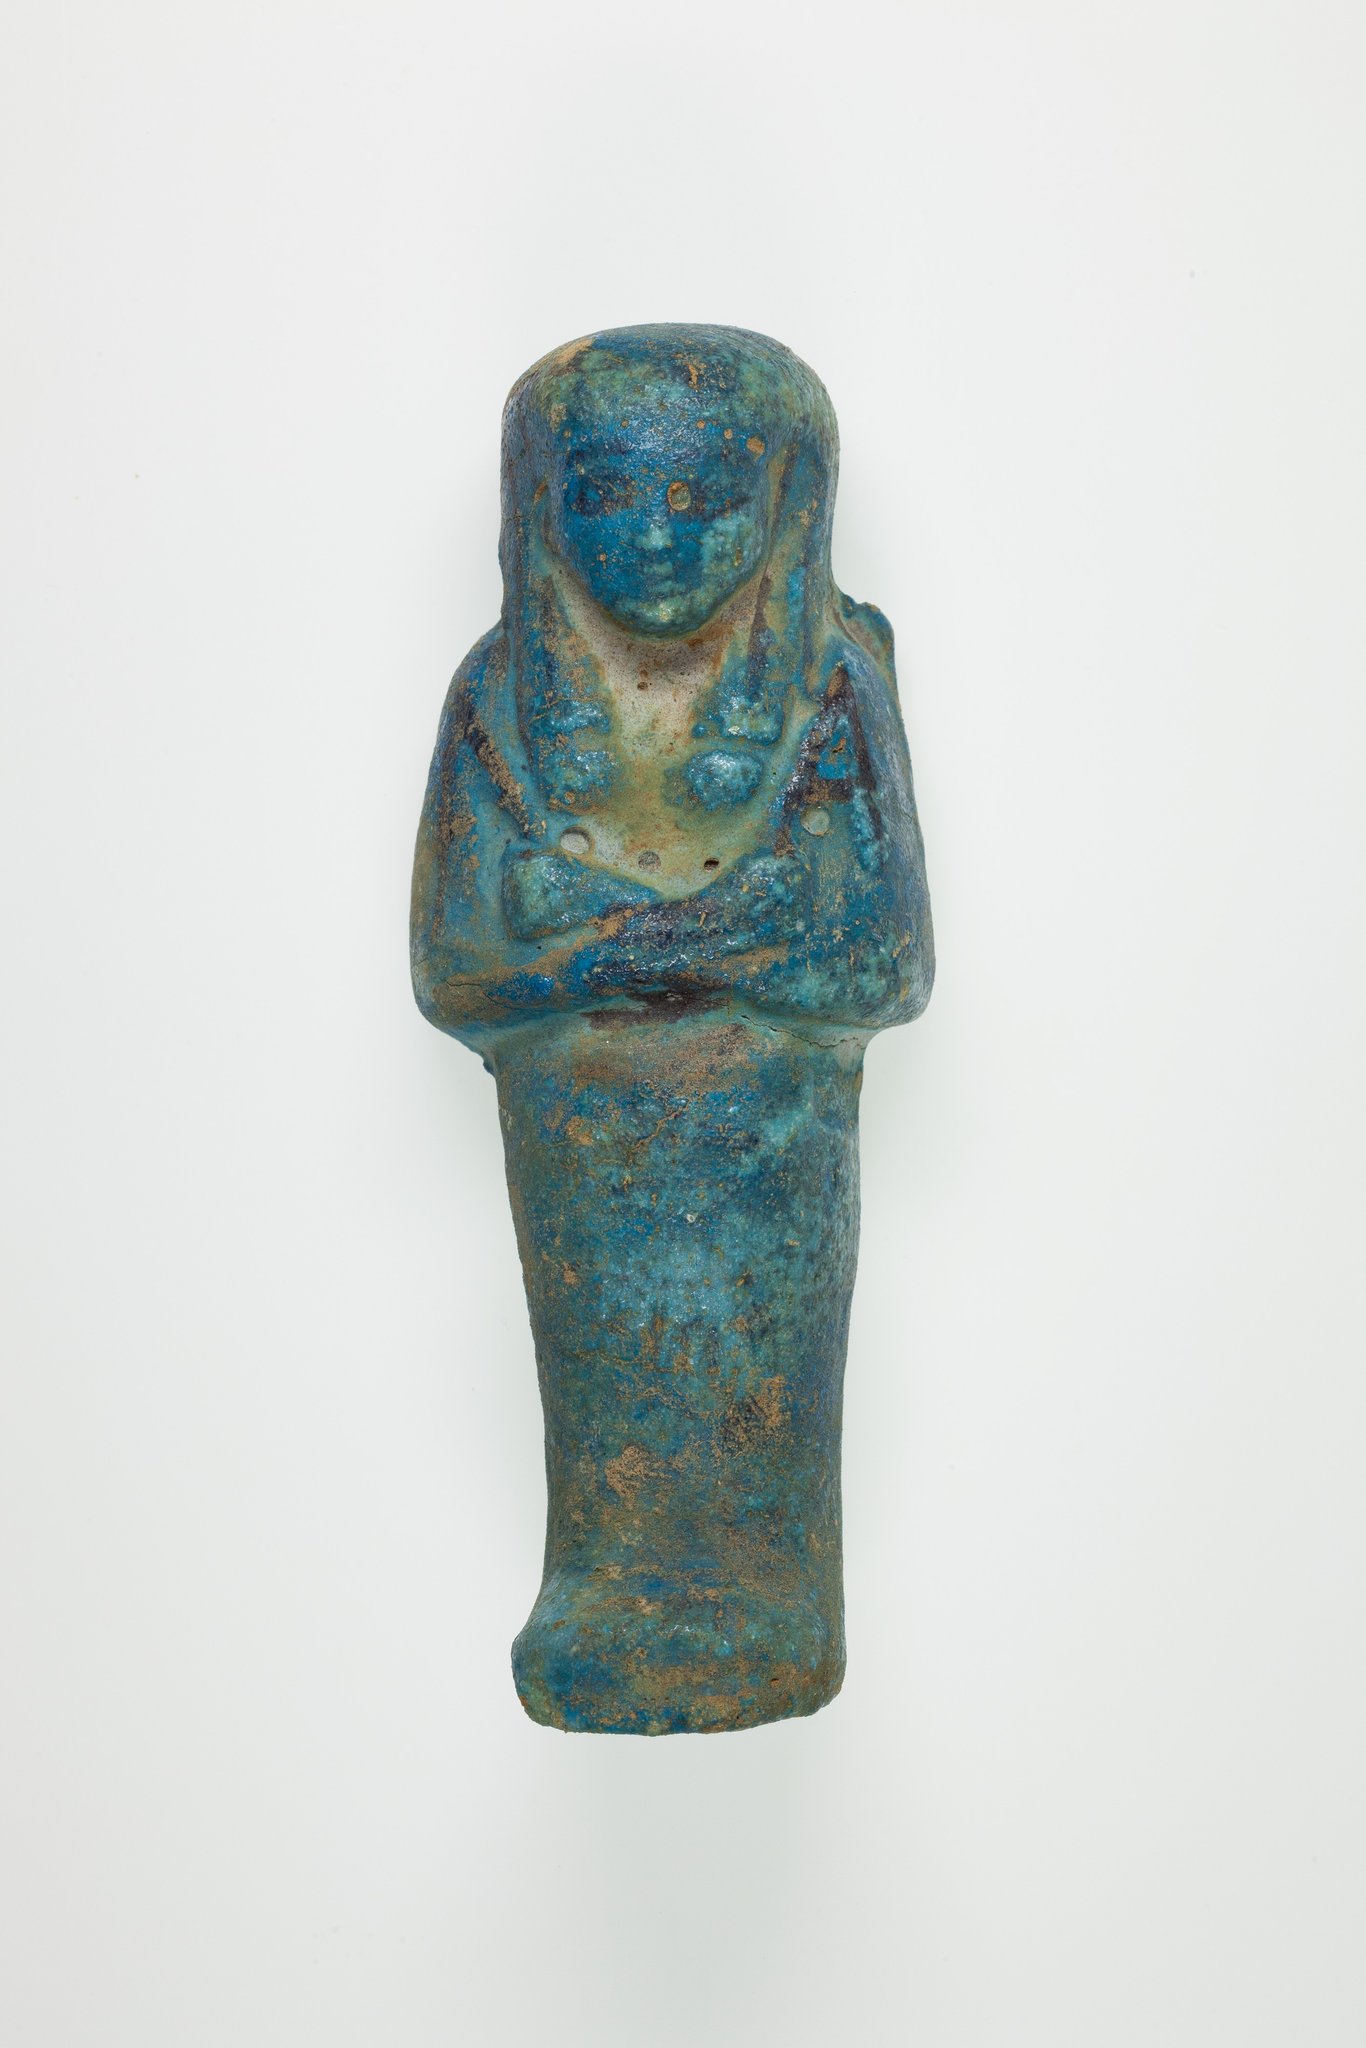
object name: shabti, henettawy c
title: Worker Shabti of Henettawy (C), Daughter of Isetemkheb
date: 990-970 BCE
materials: faience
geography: egypt